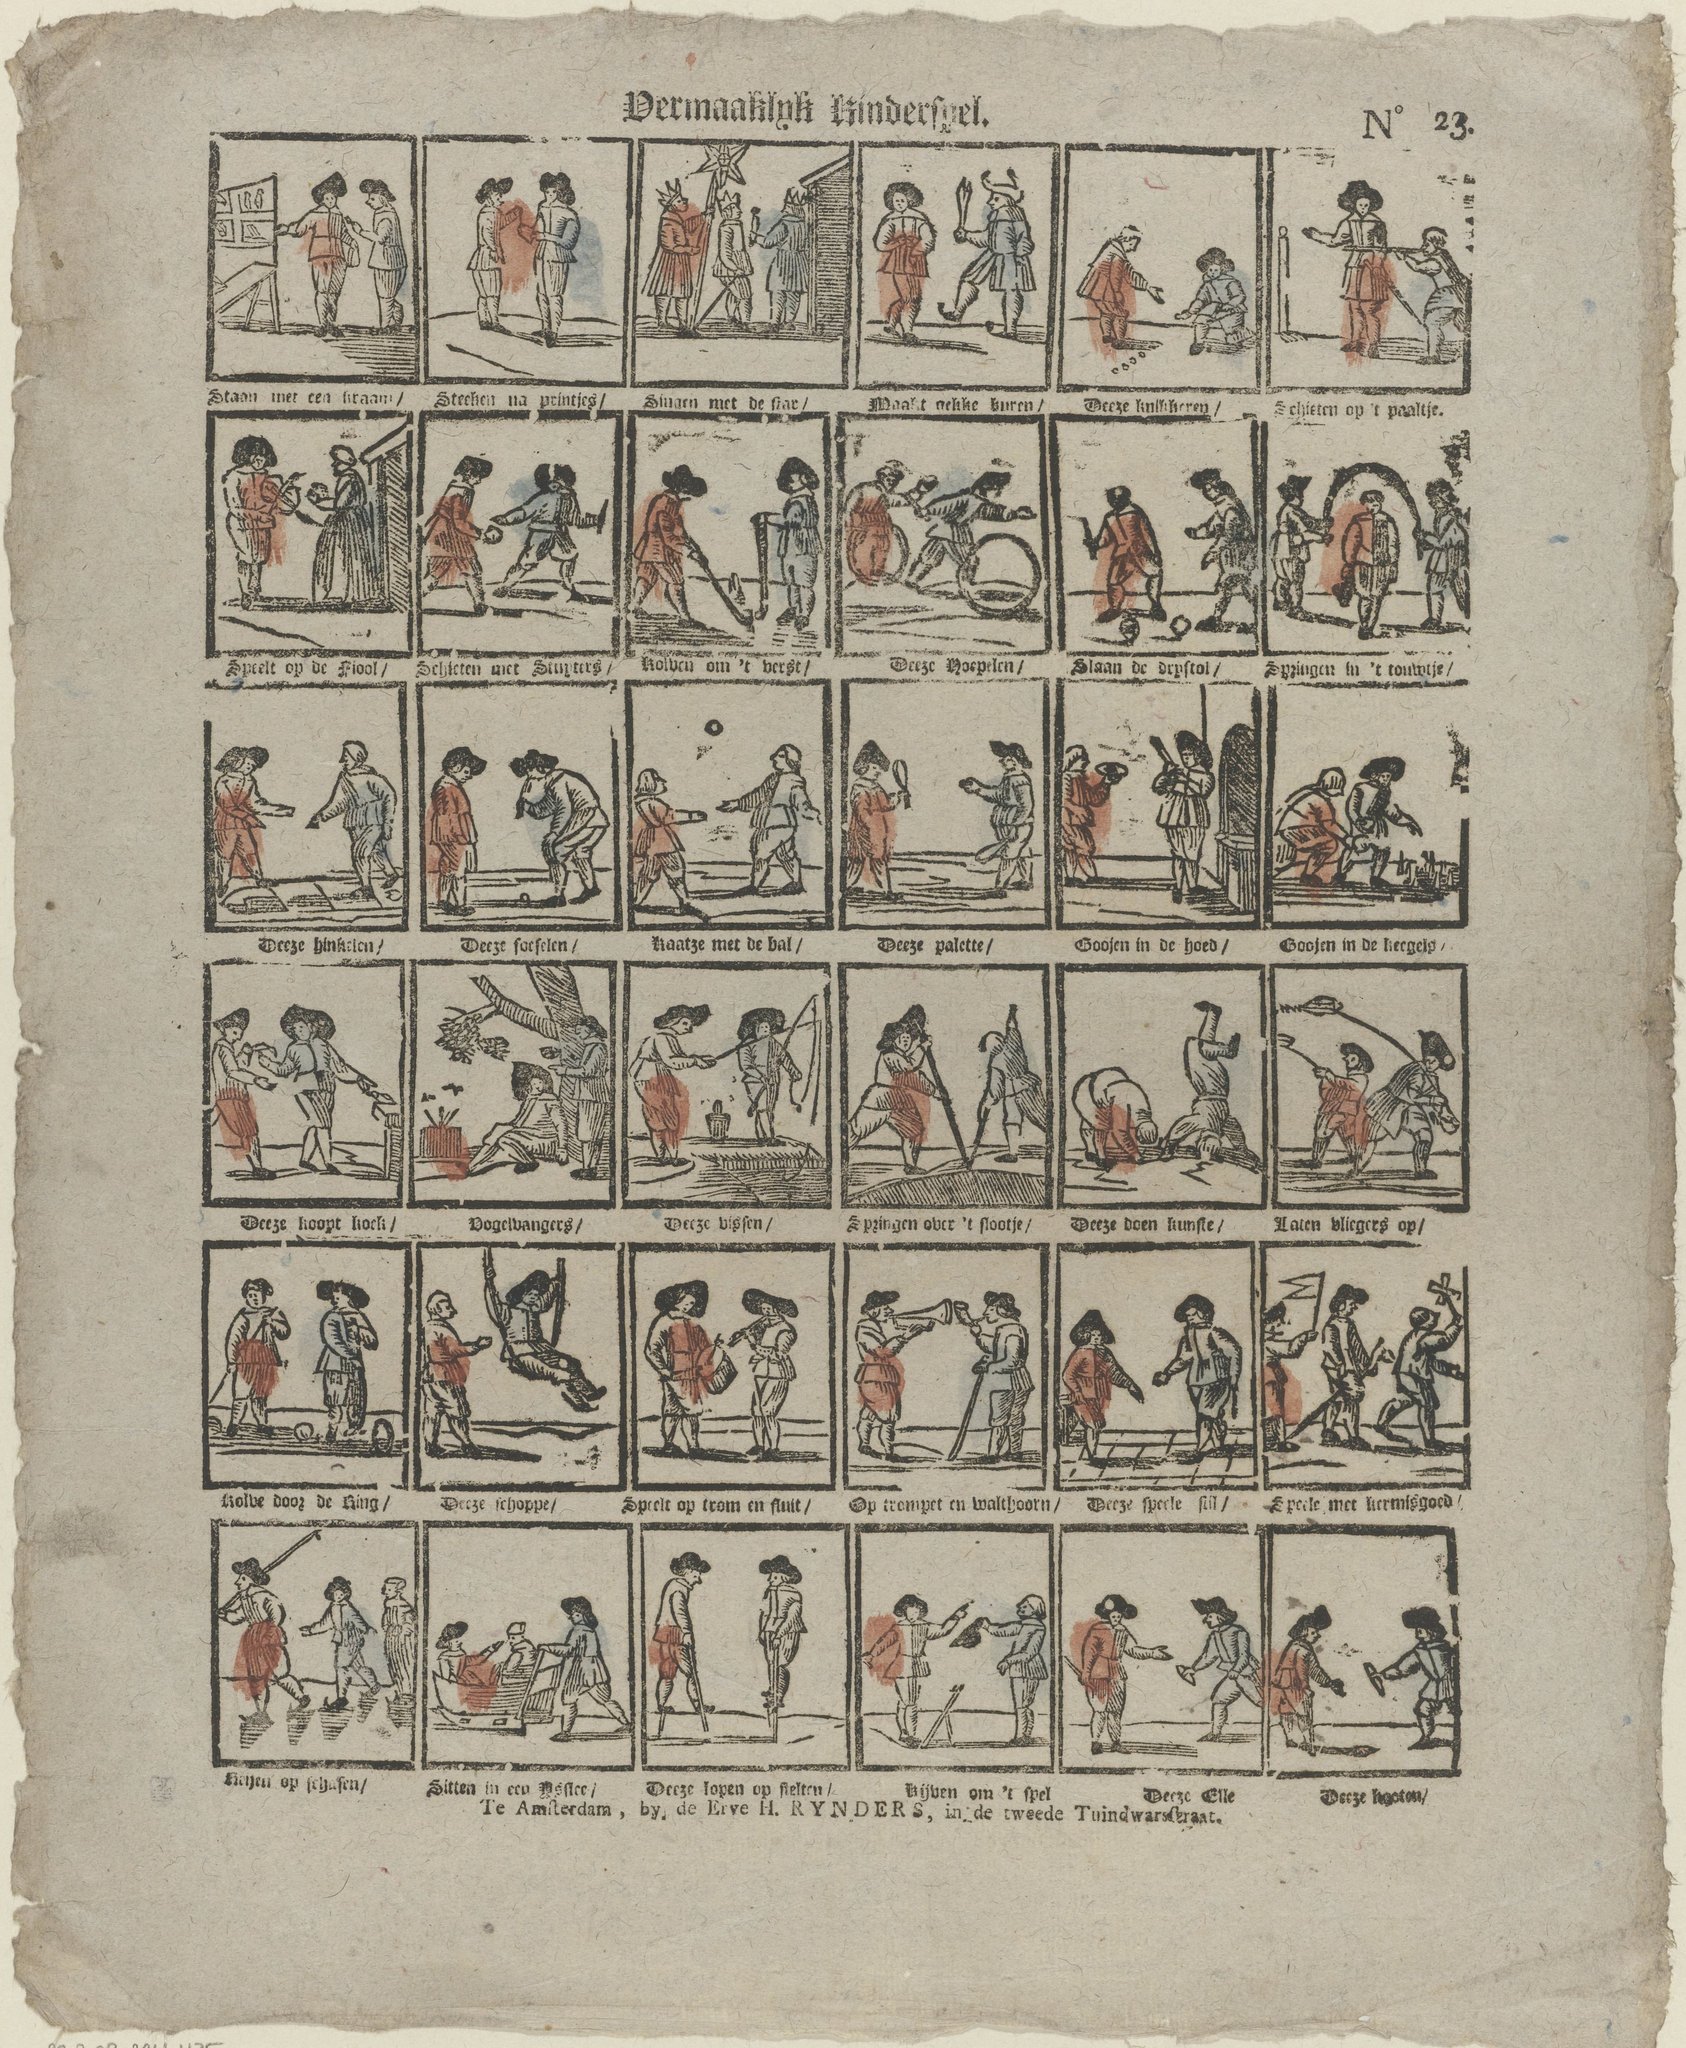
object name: popular print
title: Vermaaklyk kinderspel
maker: Anonymous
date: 1831-1854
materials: paper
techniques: colour, letterpress printing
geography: amsterdam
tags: children's games and plays, fishing (sports), (flying a) kite, games using special objects (marbles, top, hoop, etc.)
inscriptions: collector's mark: Lugt 2760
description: Blad met 36 voorstellingen van kinderspelen en bezigheden, zoals hoepelen, vliegeren en vissen. Onder elke afbeelding een onderschrift. Genummerd rechtsboven: No. 23.